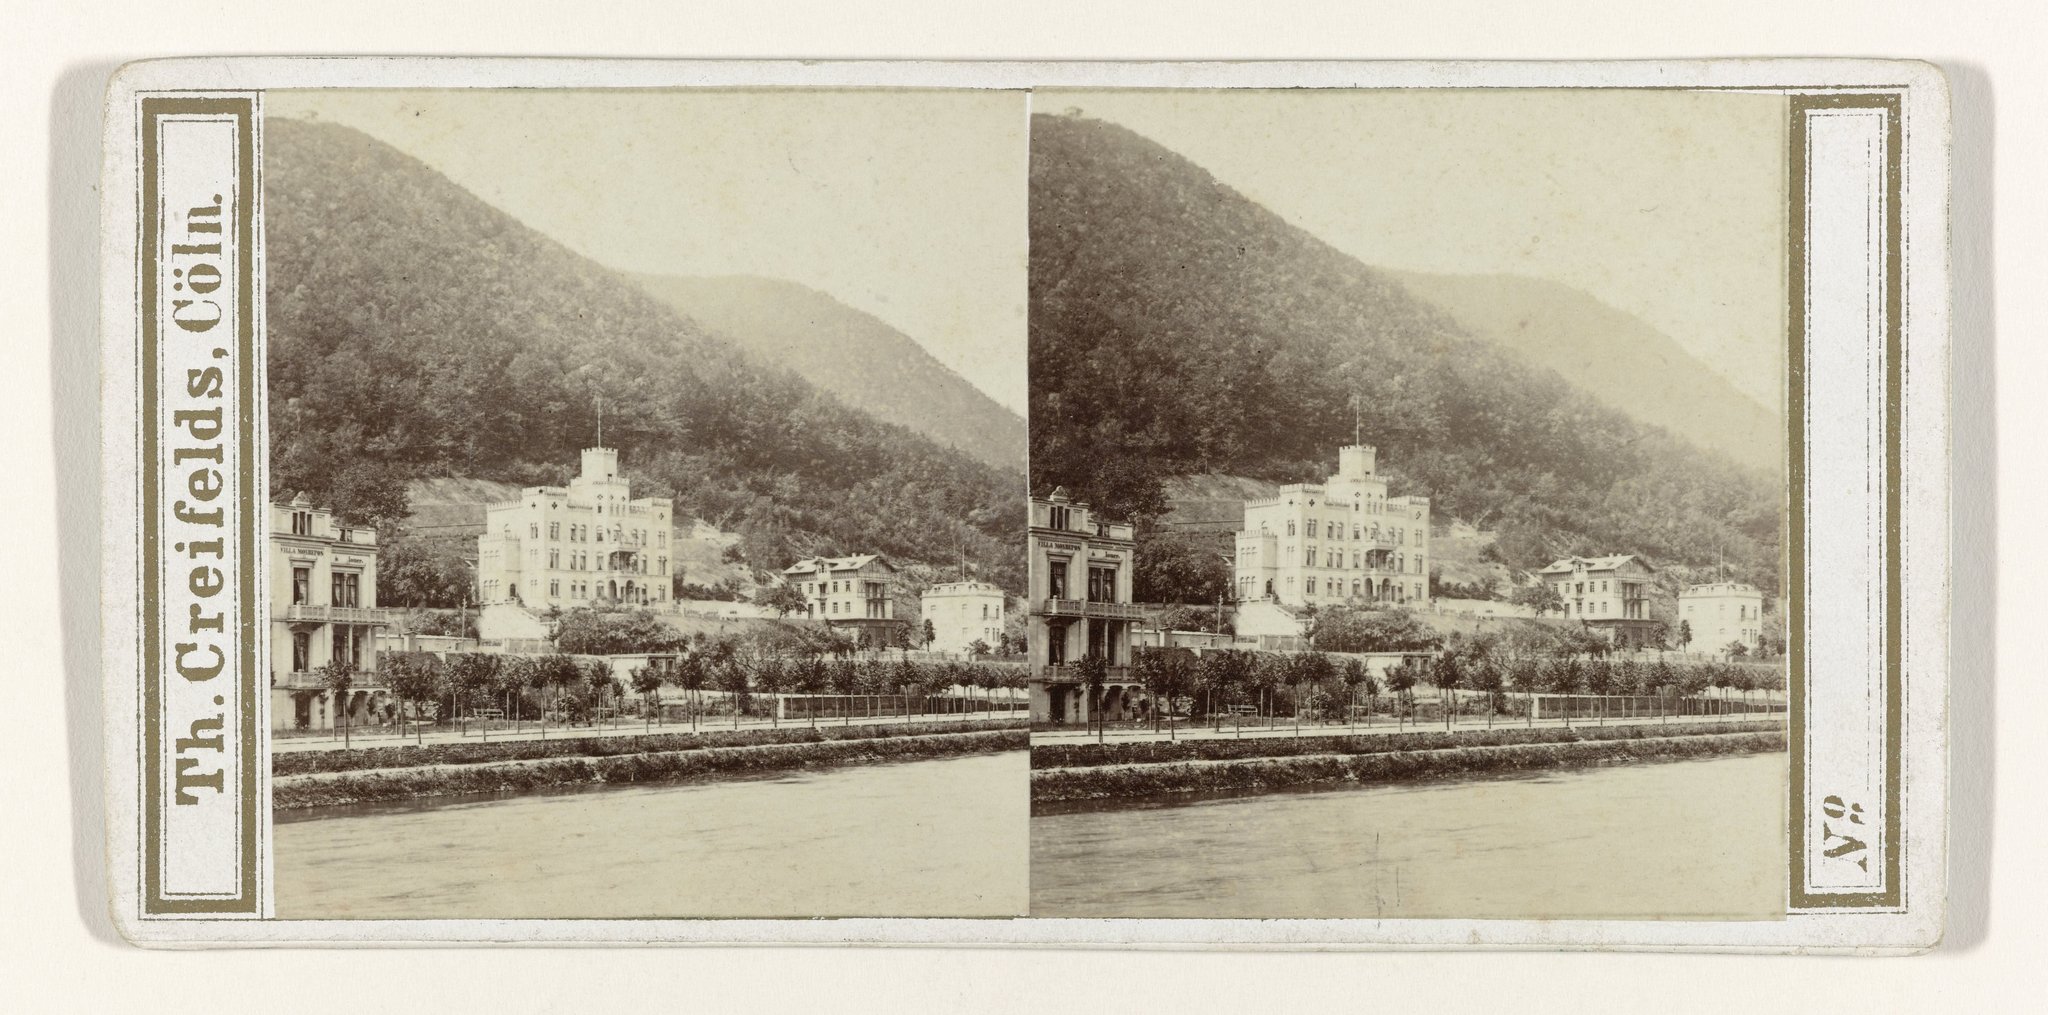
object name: stereograph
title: Gezicht op de linkeroever van de Ems in Bad Ems, Duitsland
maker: theodor creifelds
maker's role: publisher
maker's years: 1815-1875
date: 1855-1872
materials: cardboard, paper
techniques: albumen print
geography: bad ems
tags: dale, valley, river bank, village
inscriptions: date: ‘Do. 14 Aug s 1872’, number: ‘Nro. 521.’